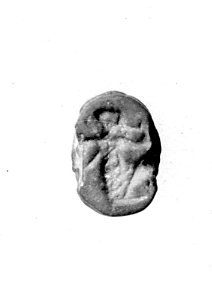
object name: scarab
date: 1353-1336 BCE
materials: faience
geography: egypt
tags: scarabs